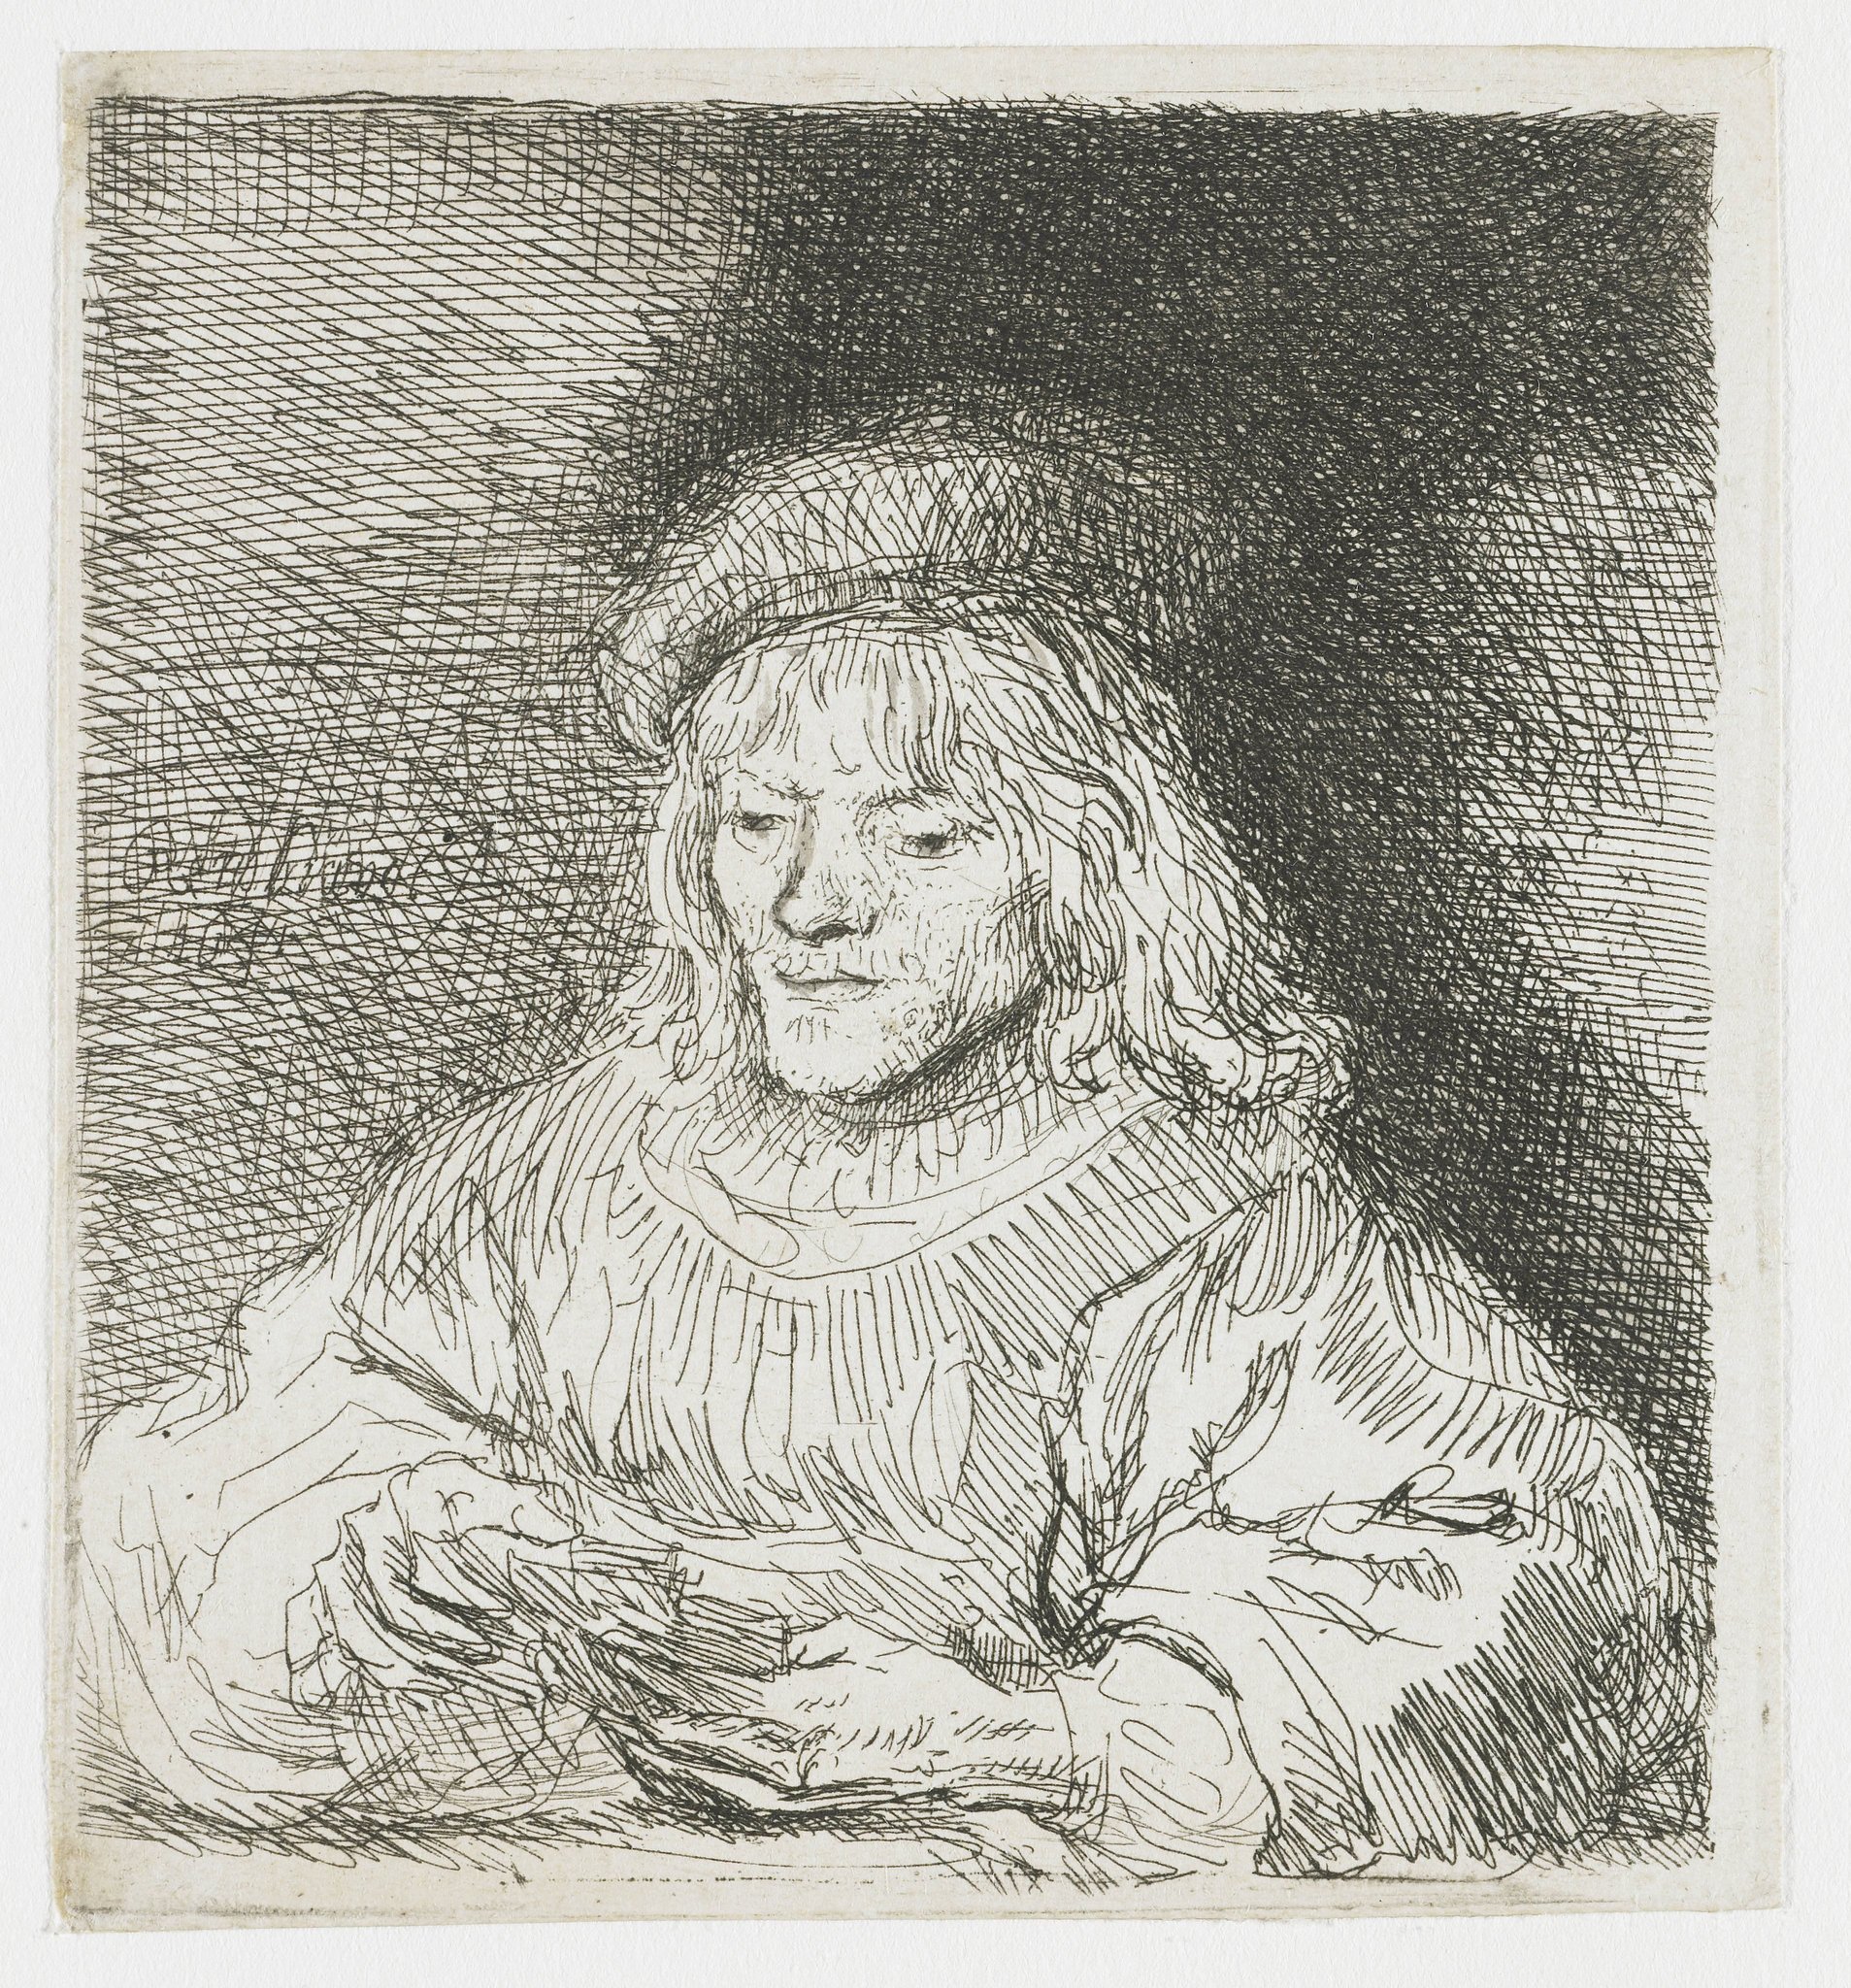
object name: print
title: The card player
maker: rembrandt van rijn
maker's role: draughtsman, painter, print maker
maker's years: 1606-1669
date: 1641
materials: paper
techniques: etching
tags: card games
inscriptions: signature and date: ‘Rembrandt f 1641’, collector's mark: Lugt 2228